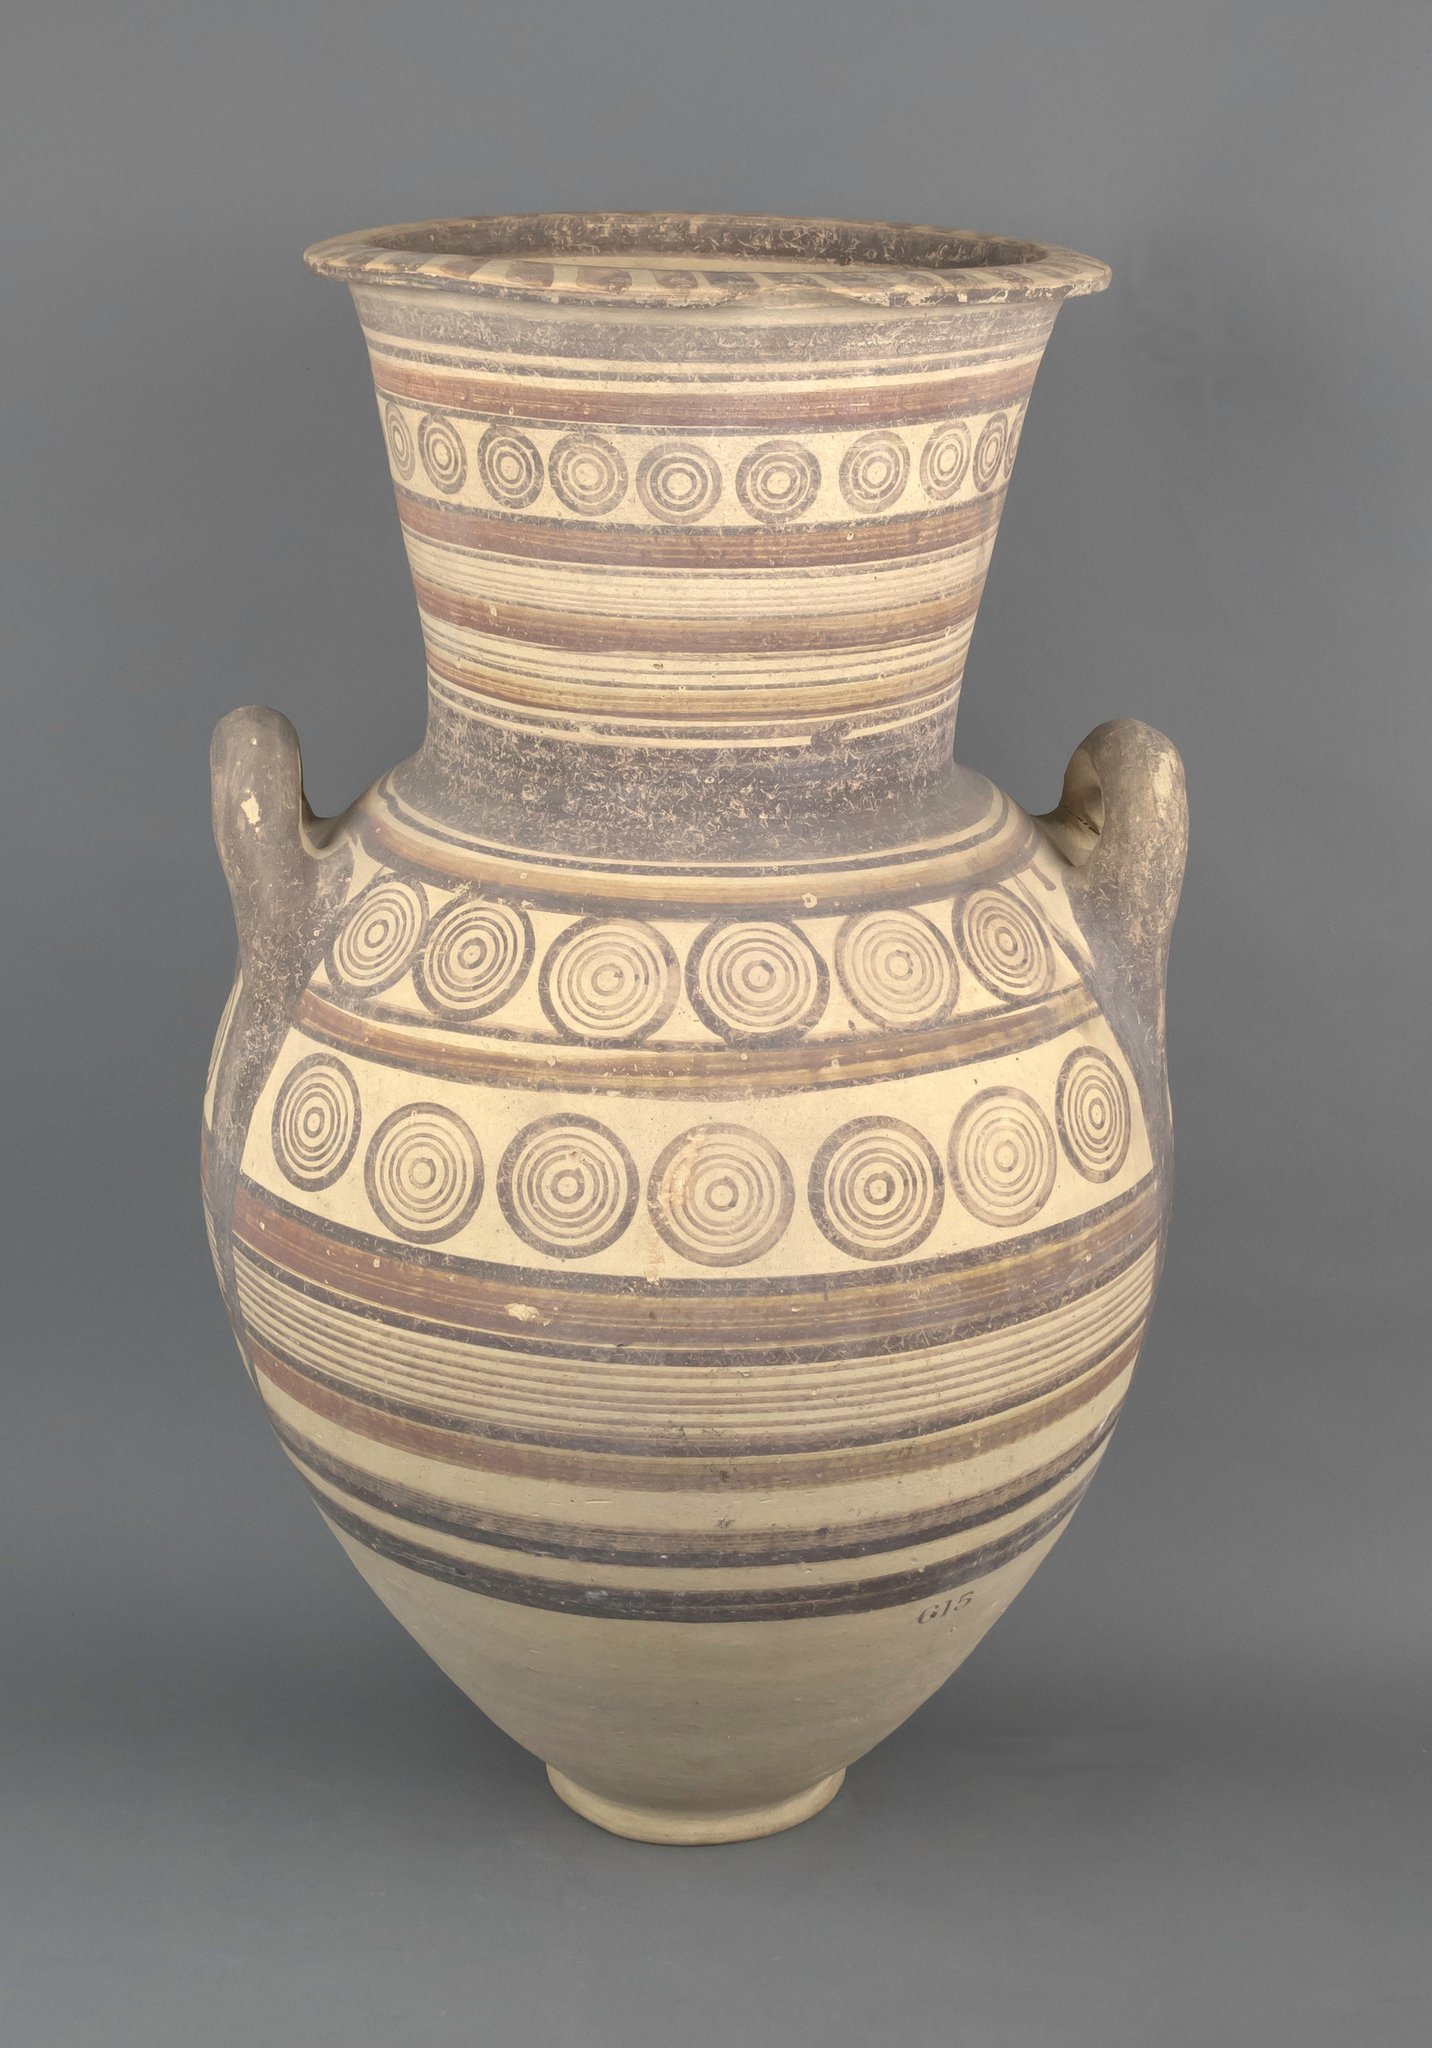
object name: amphora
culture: cypriot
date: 1050-900 BCE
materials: terracotta